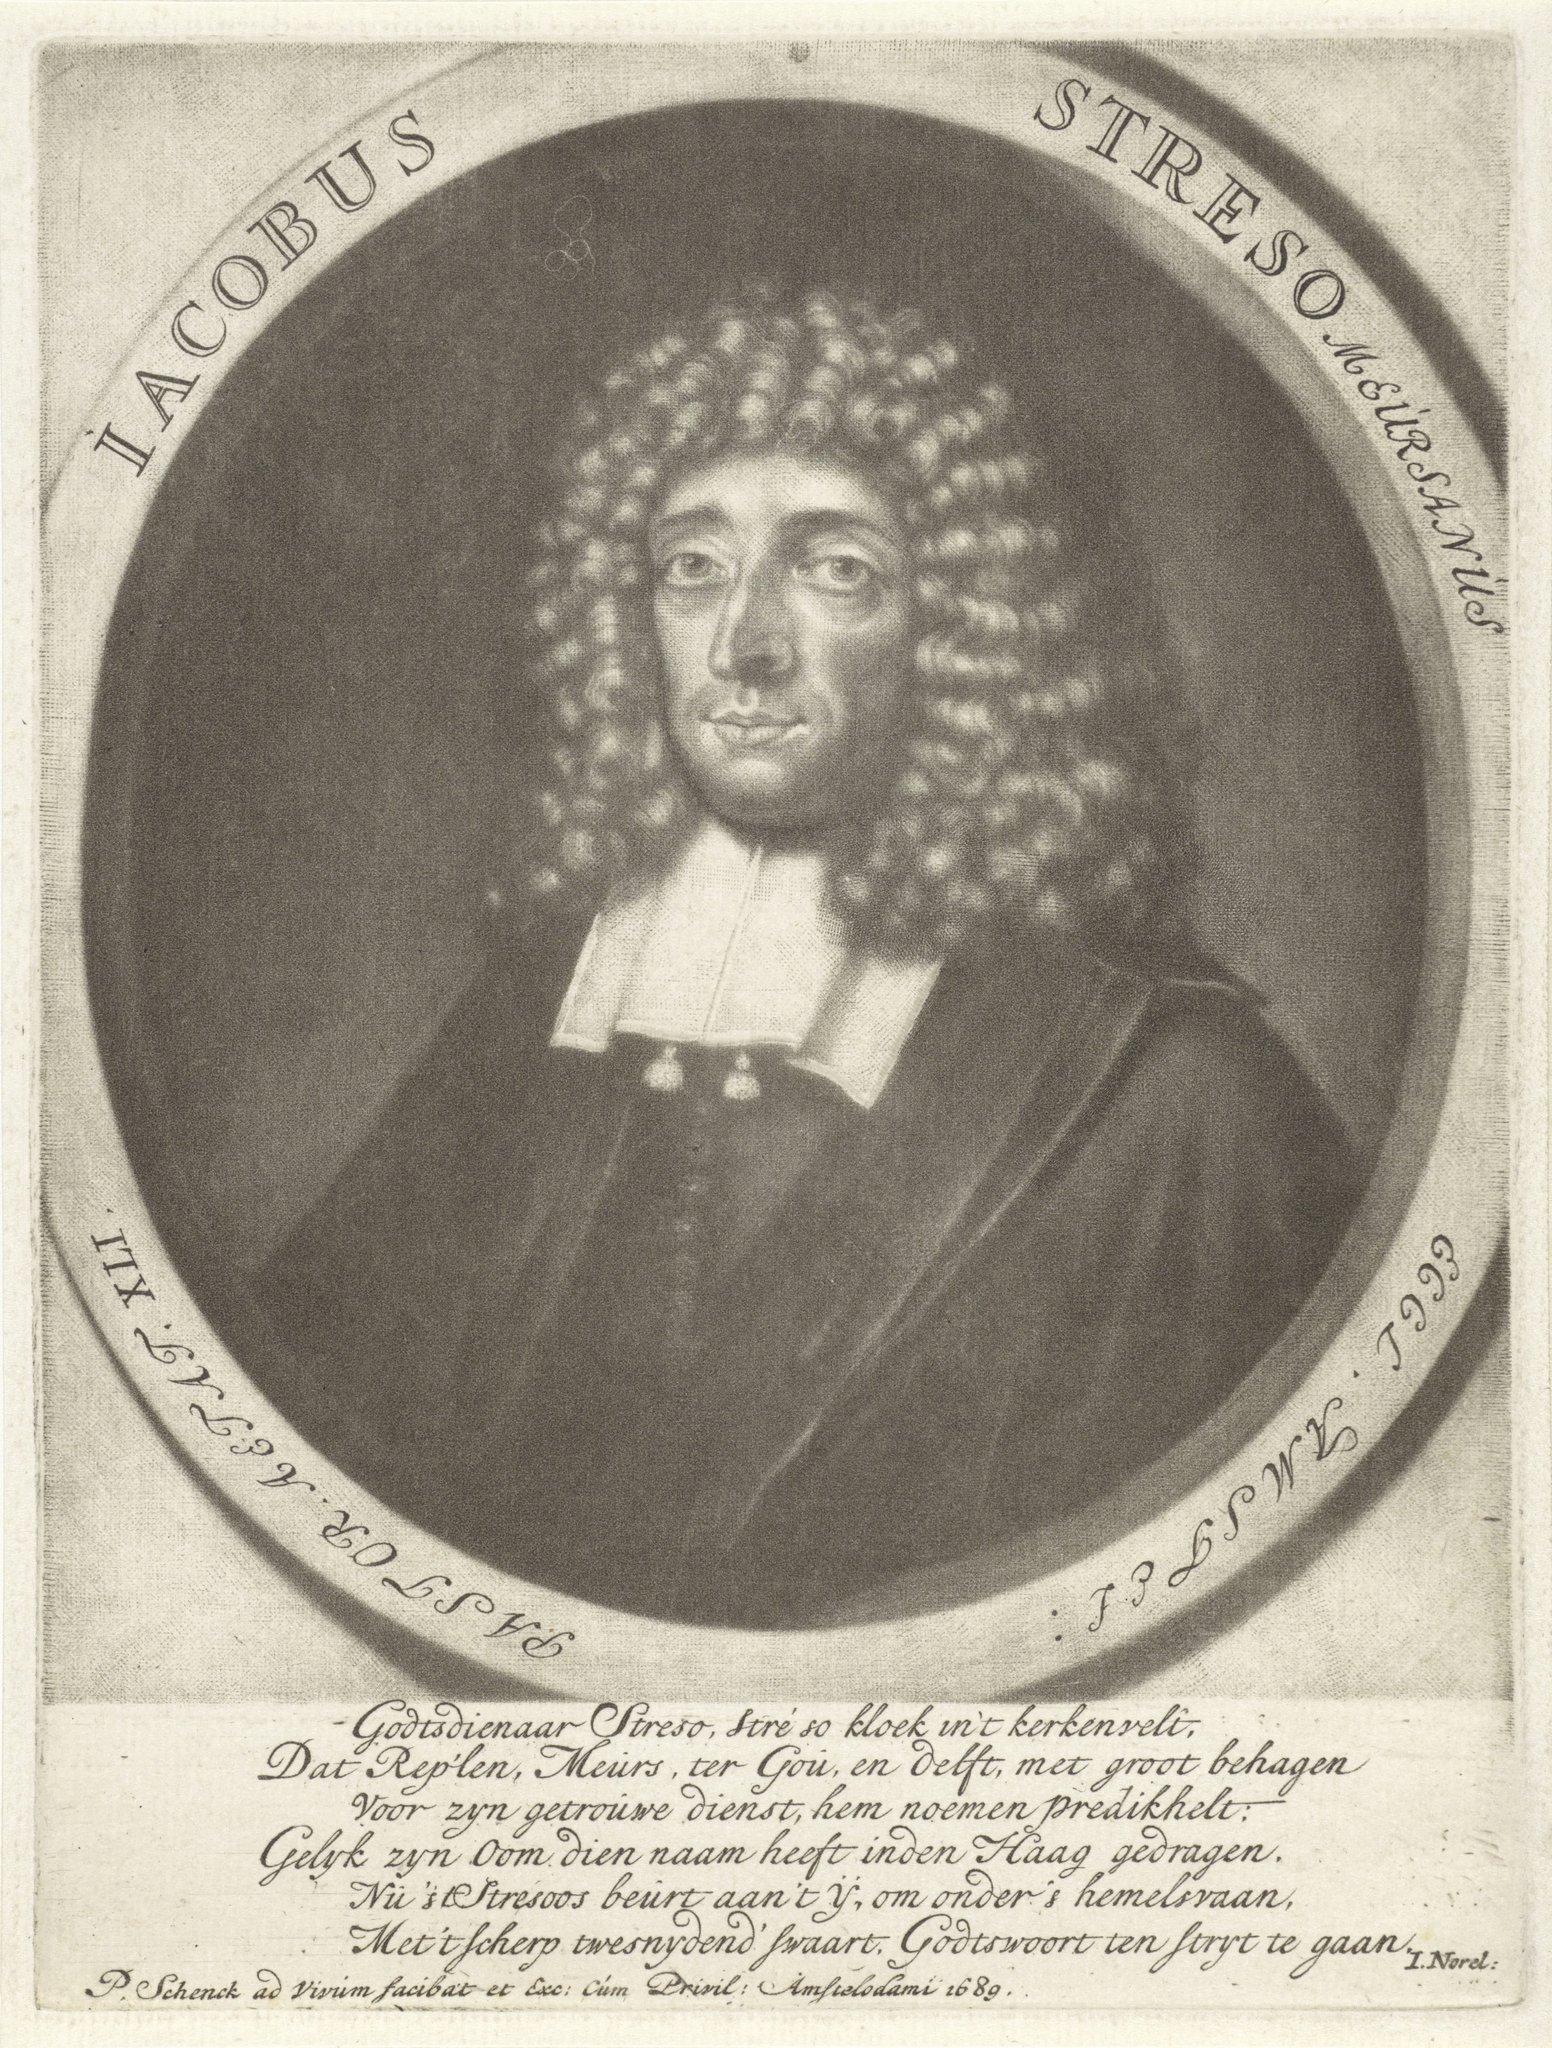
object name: print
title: Portret van de predikant Jacobus Streso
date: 1689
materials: paper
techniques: engraving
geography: amsterdam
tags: amsterdam, wig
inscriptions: collector's mark: Lugt 2228